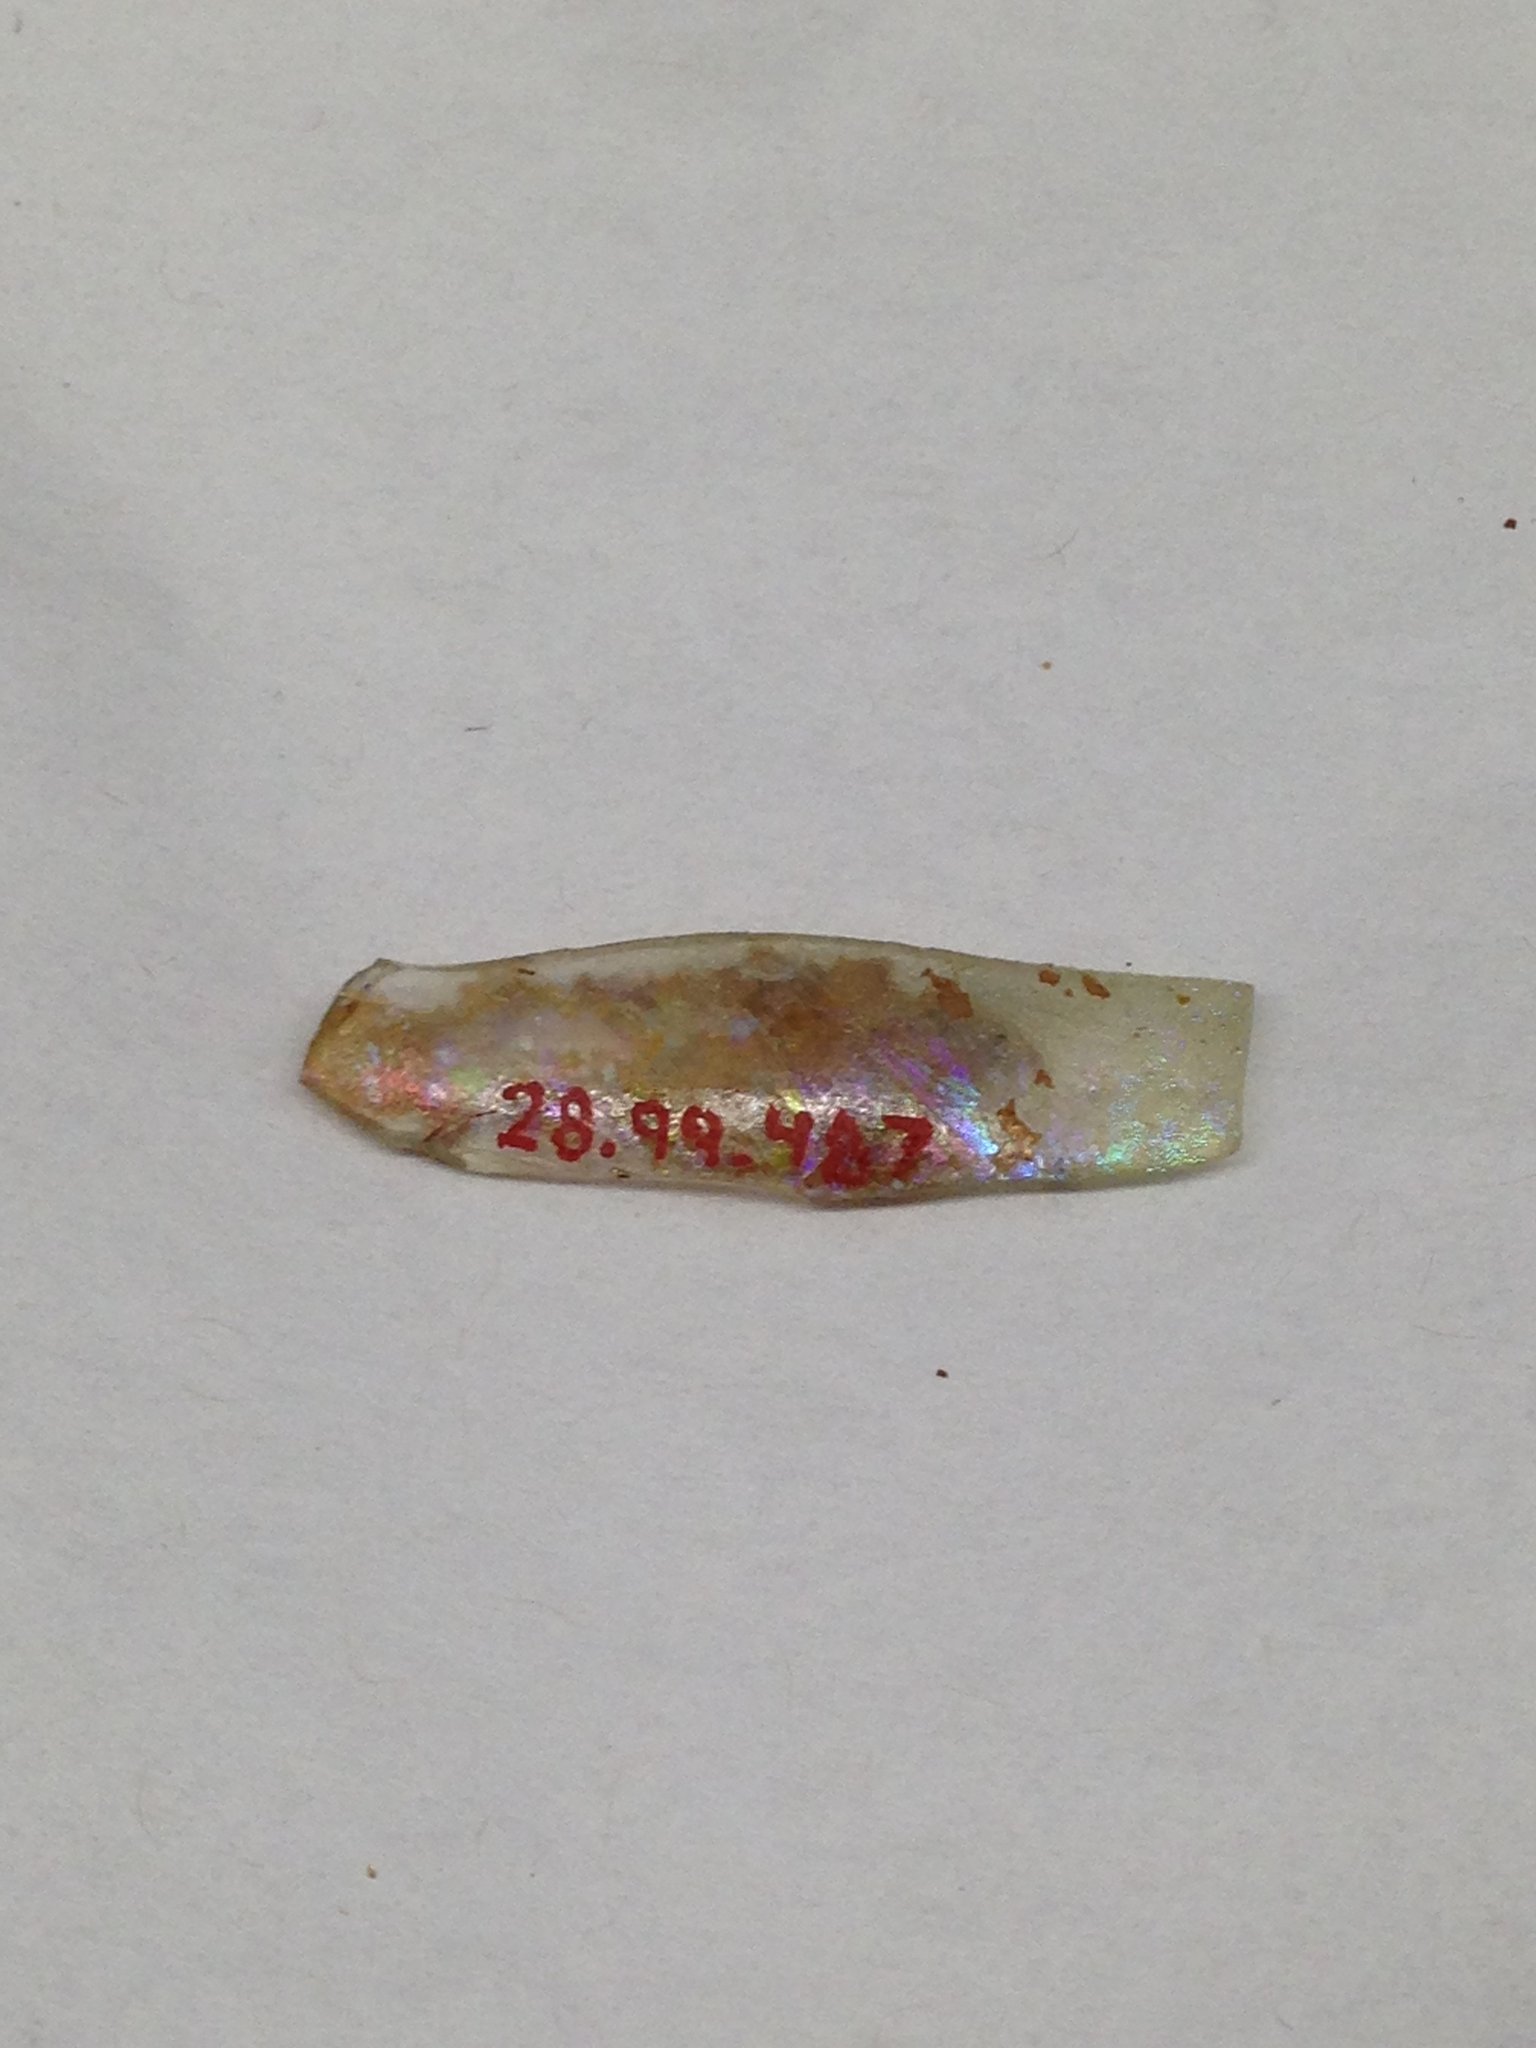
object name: fragment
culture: european or middle eastern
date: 1150-1250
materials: ceramic, glass